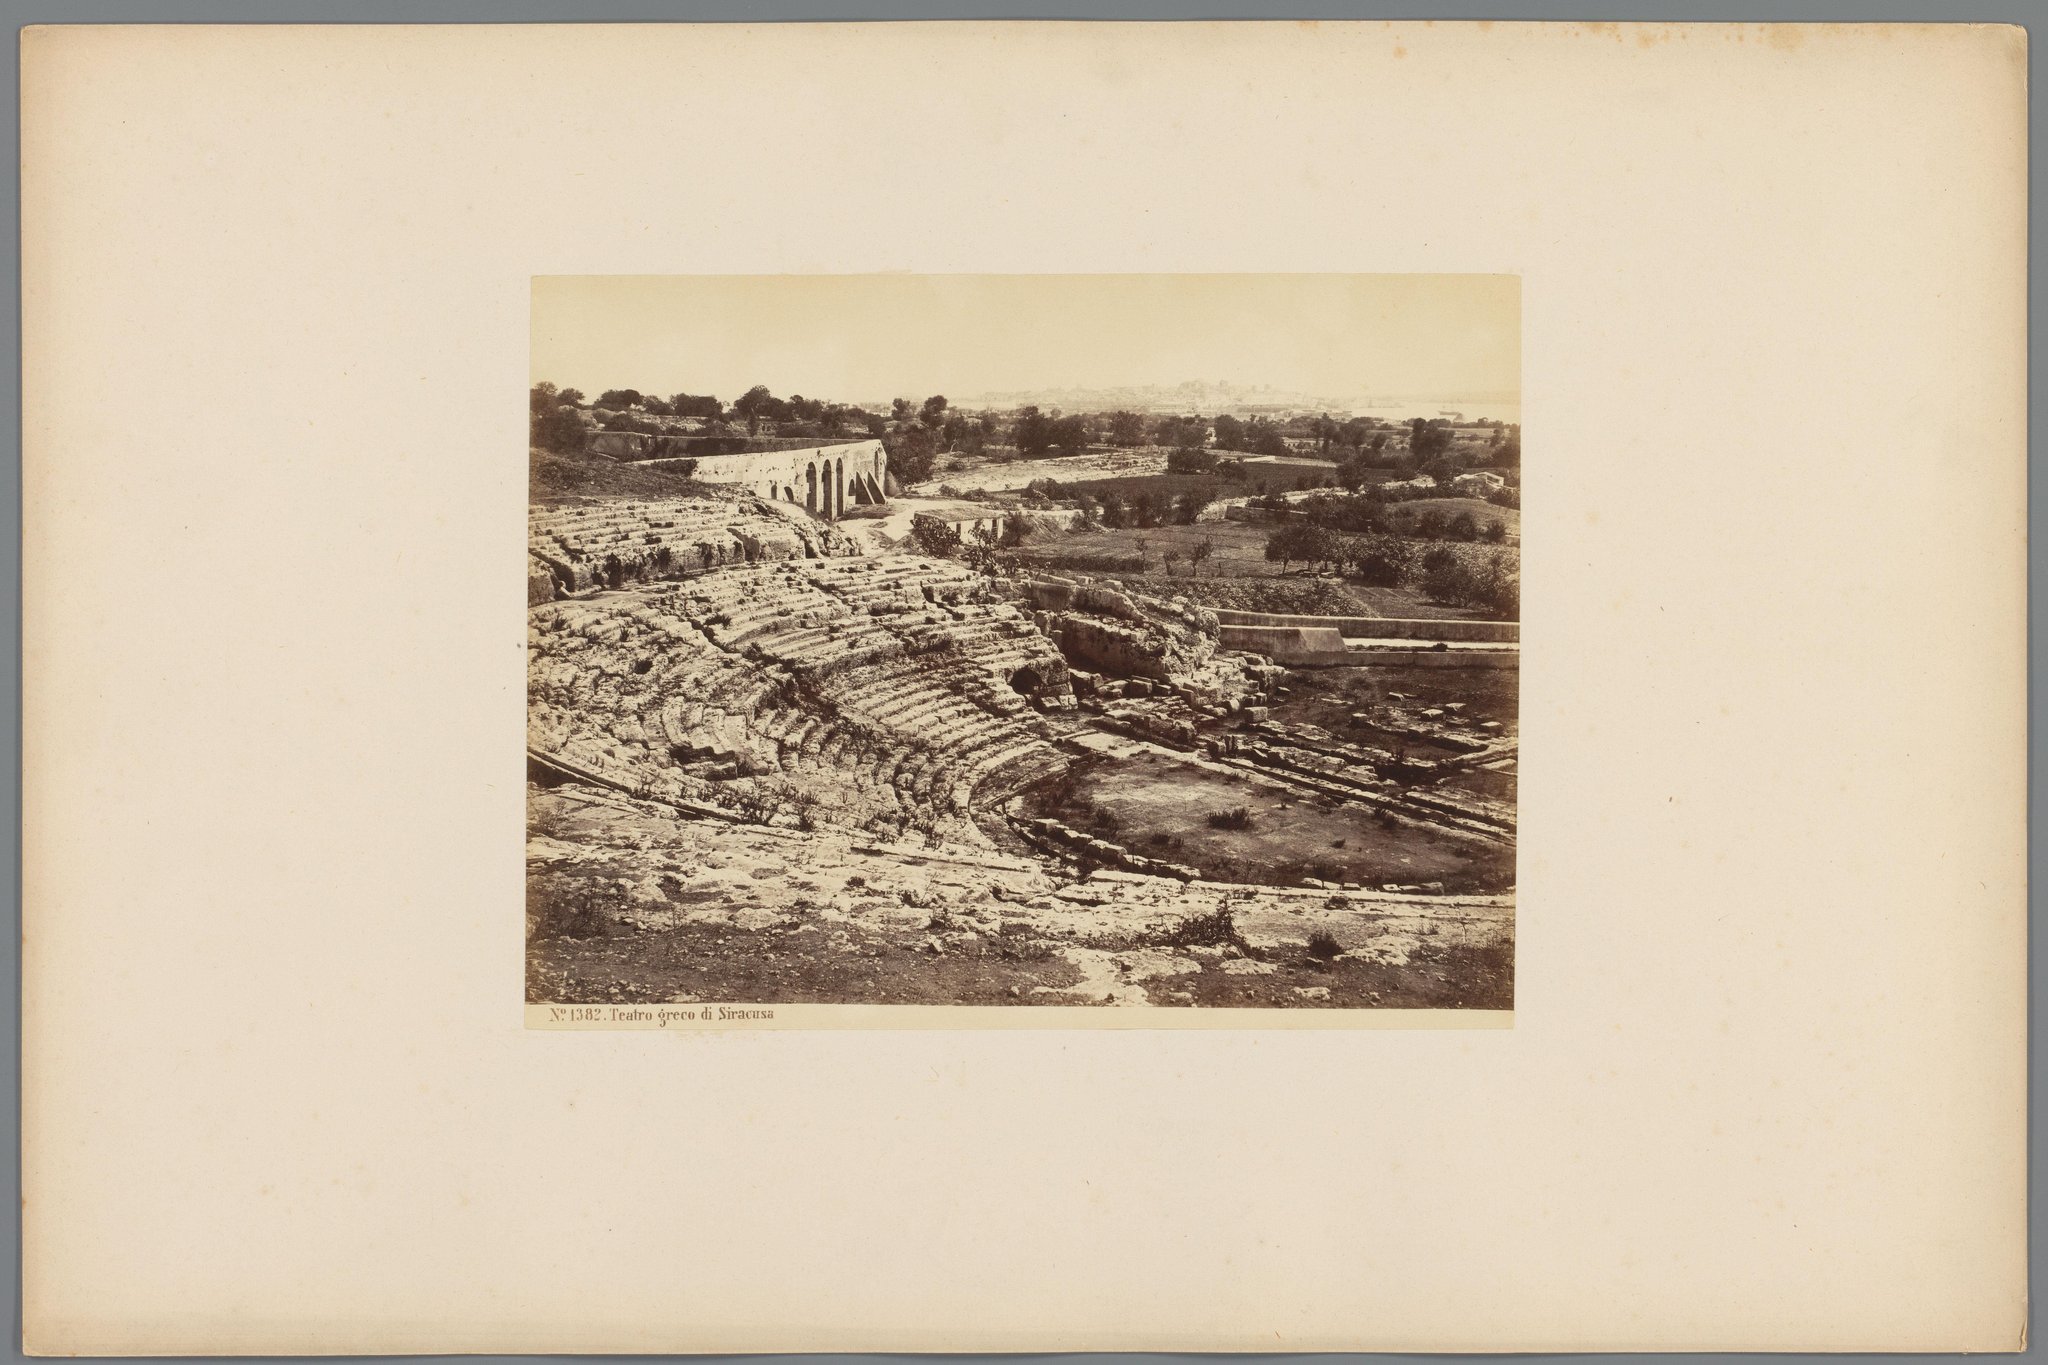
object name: photograph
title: Gezicht in het Grieks theater te Siracusa, Italië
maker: Anonymous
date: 1851-1900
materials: cardboard, paper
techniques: albumen print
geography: syracuse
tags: ruin of a building ~ architecture, amphitheatre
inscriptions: number: ‘No. 1382’